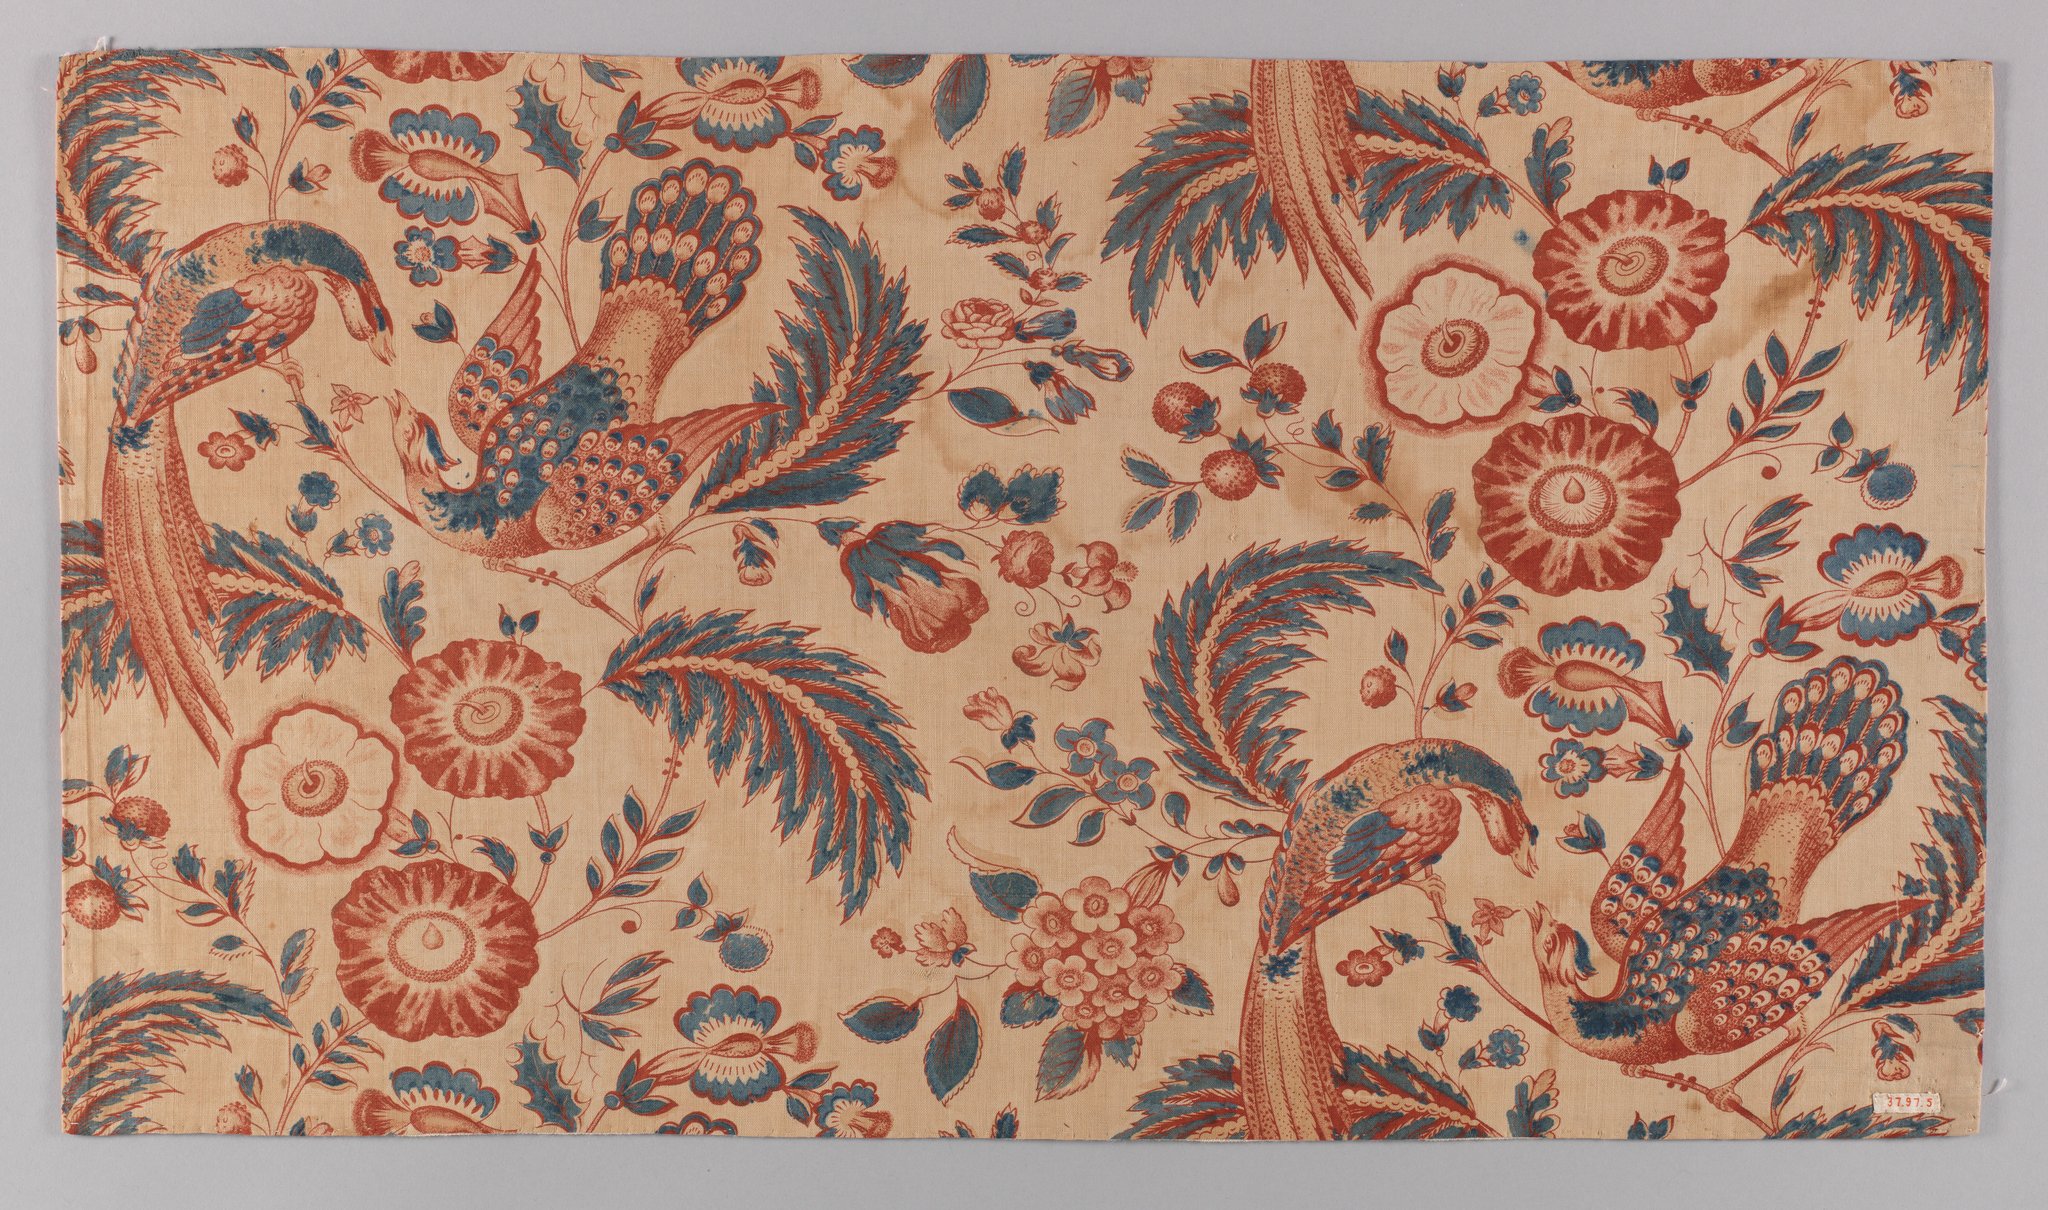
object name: piece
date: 1830-1835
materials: cotton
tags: birds